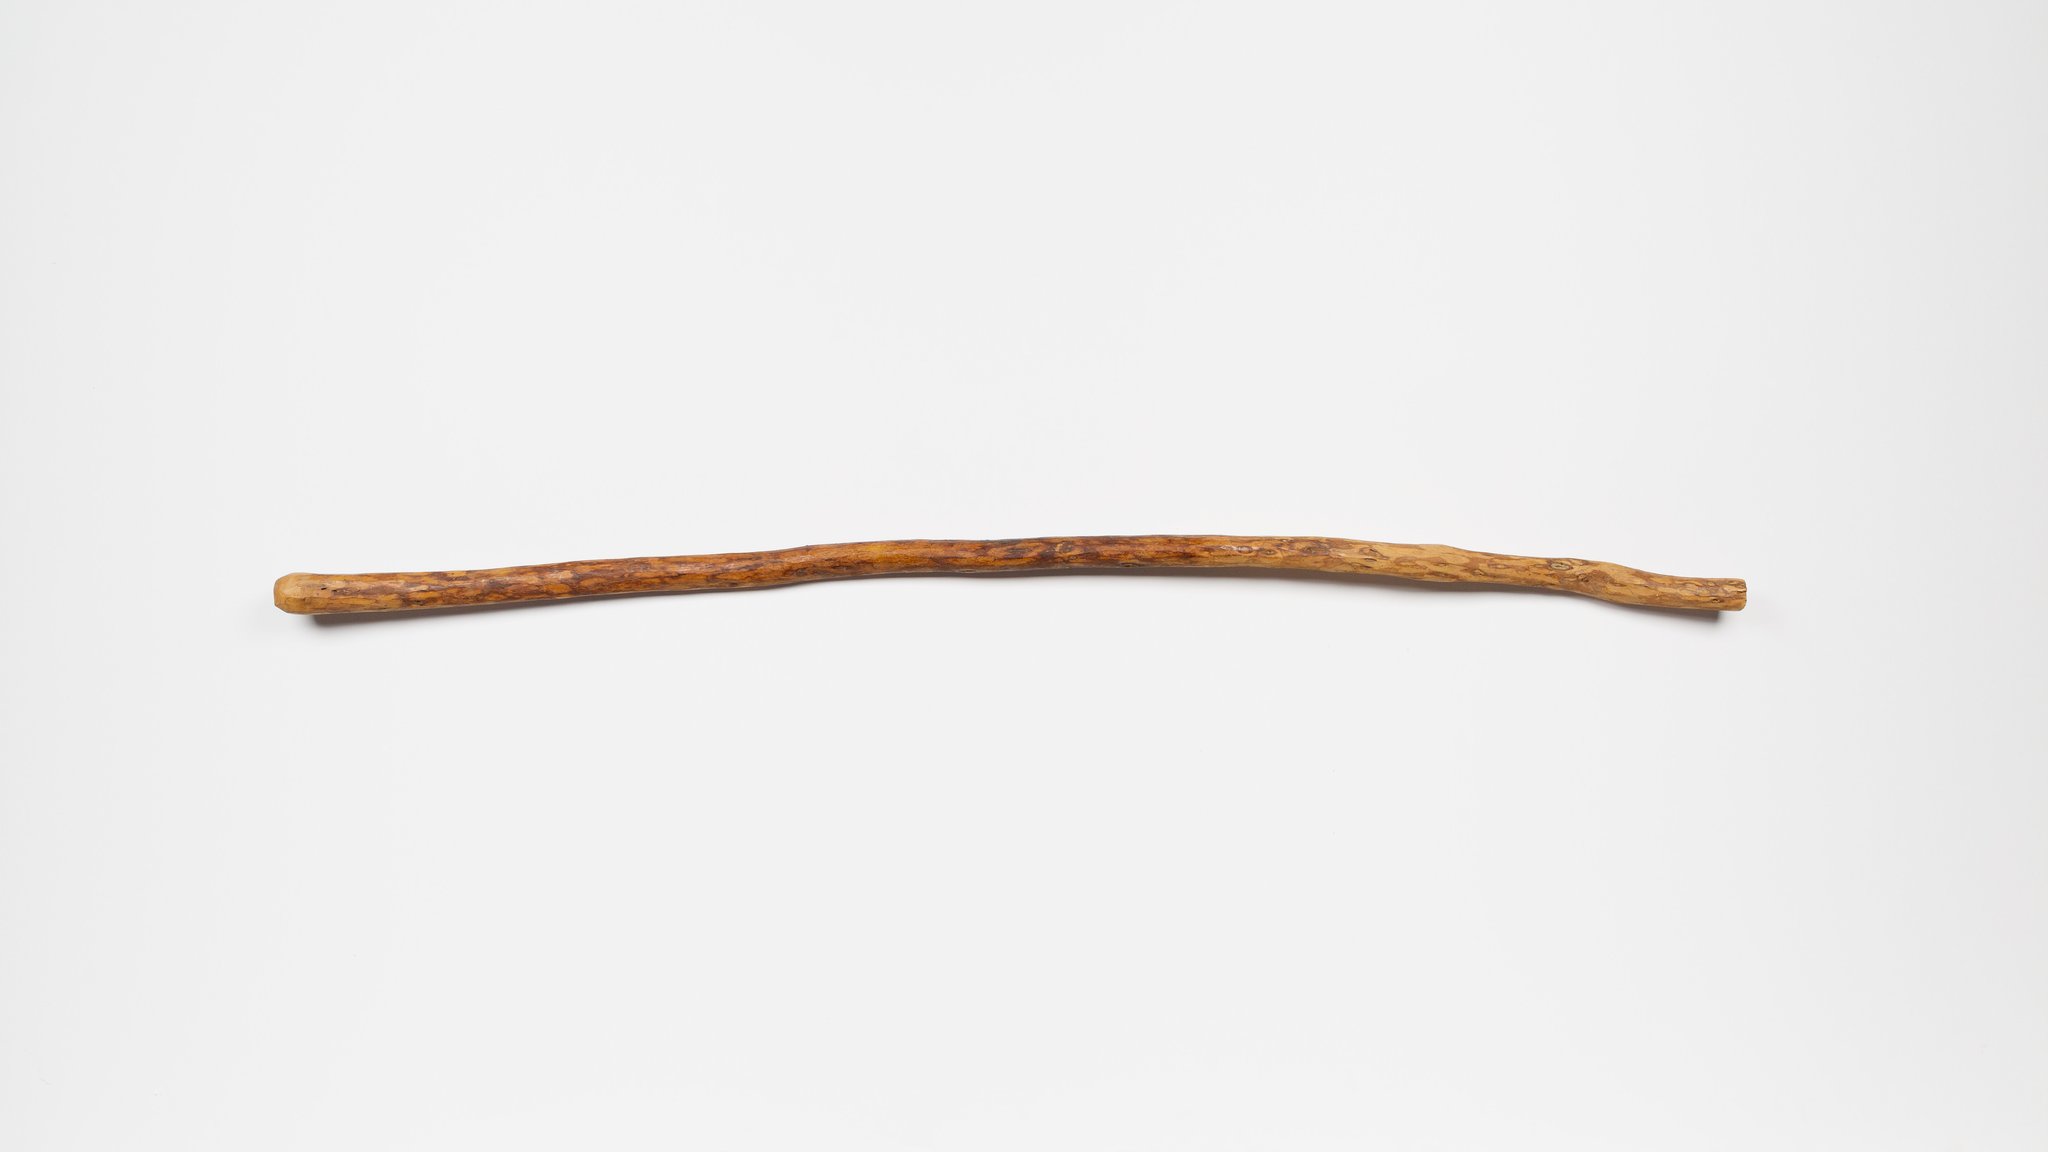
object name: staff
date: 1981-1975 BCE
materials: wood